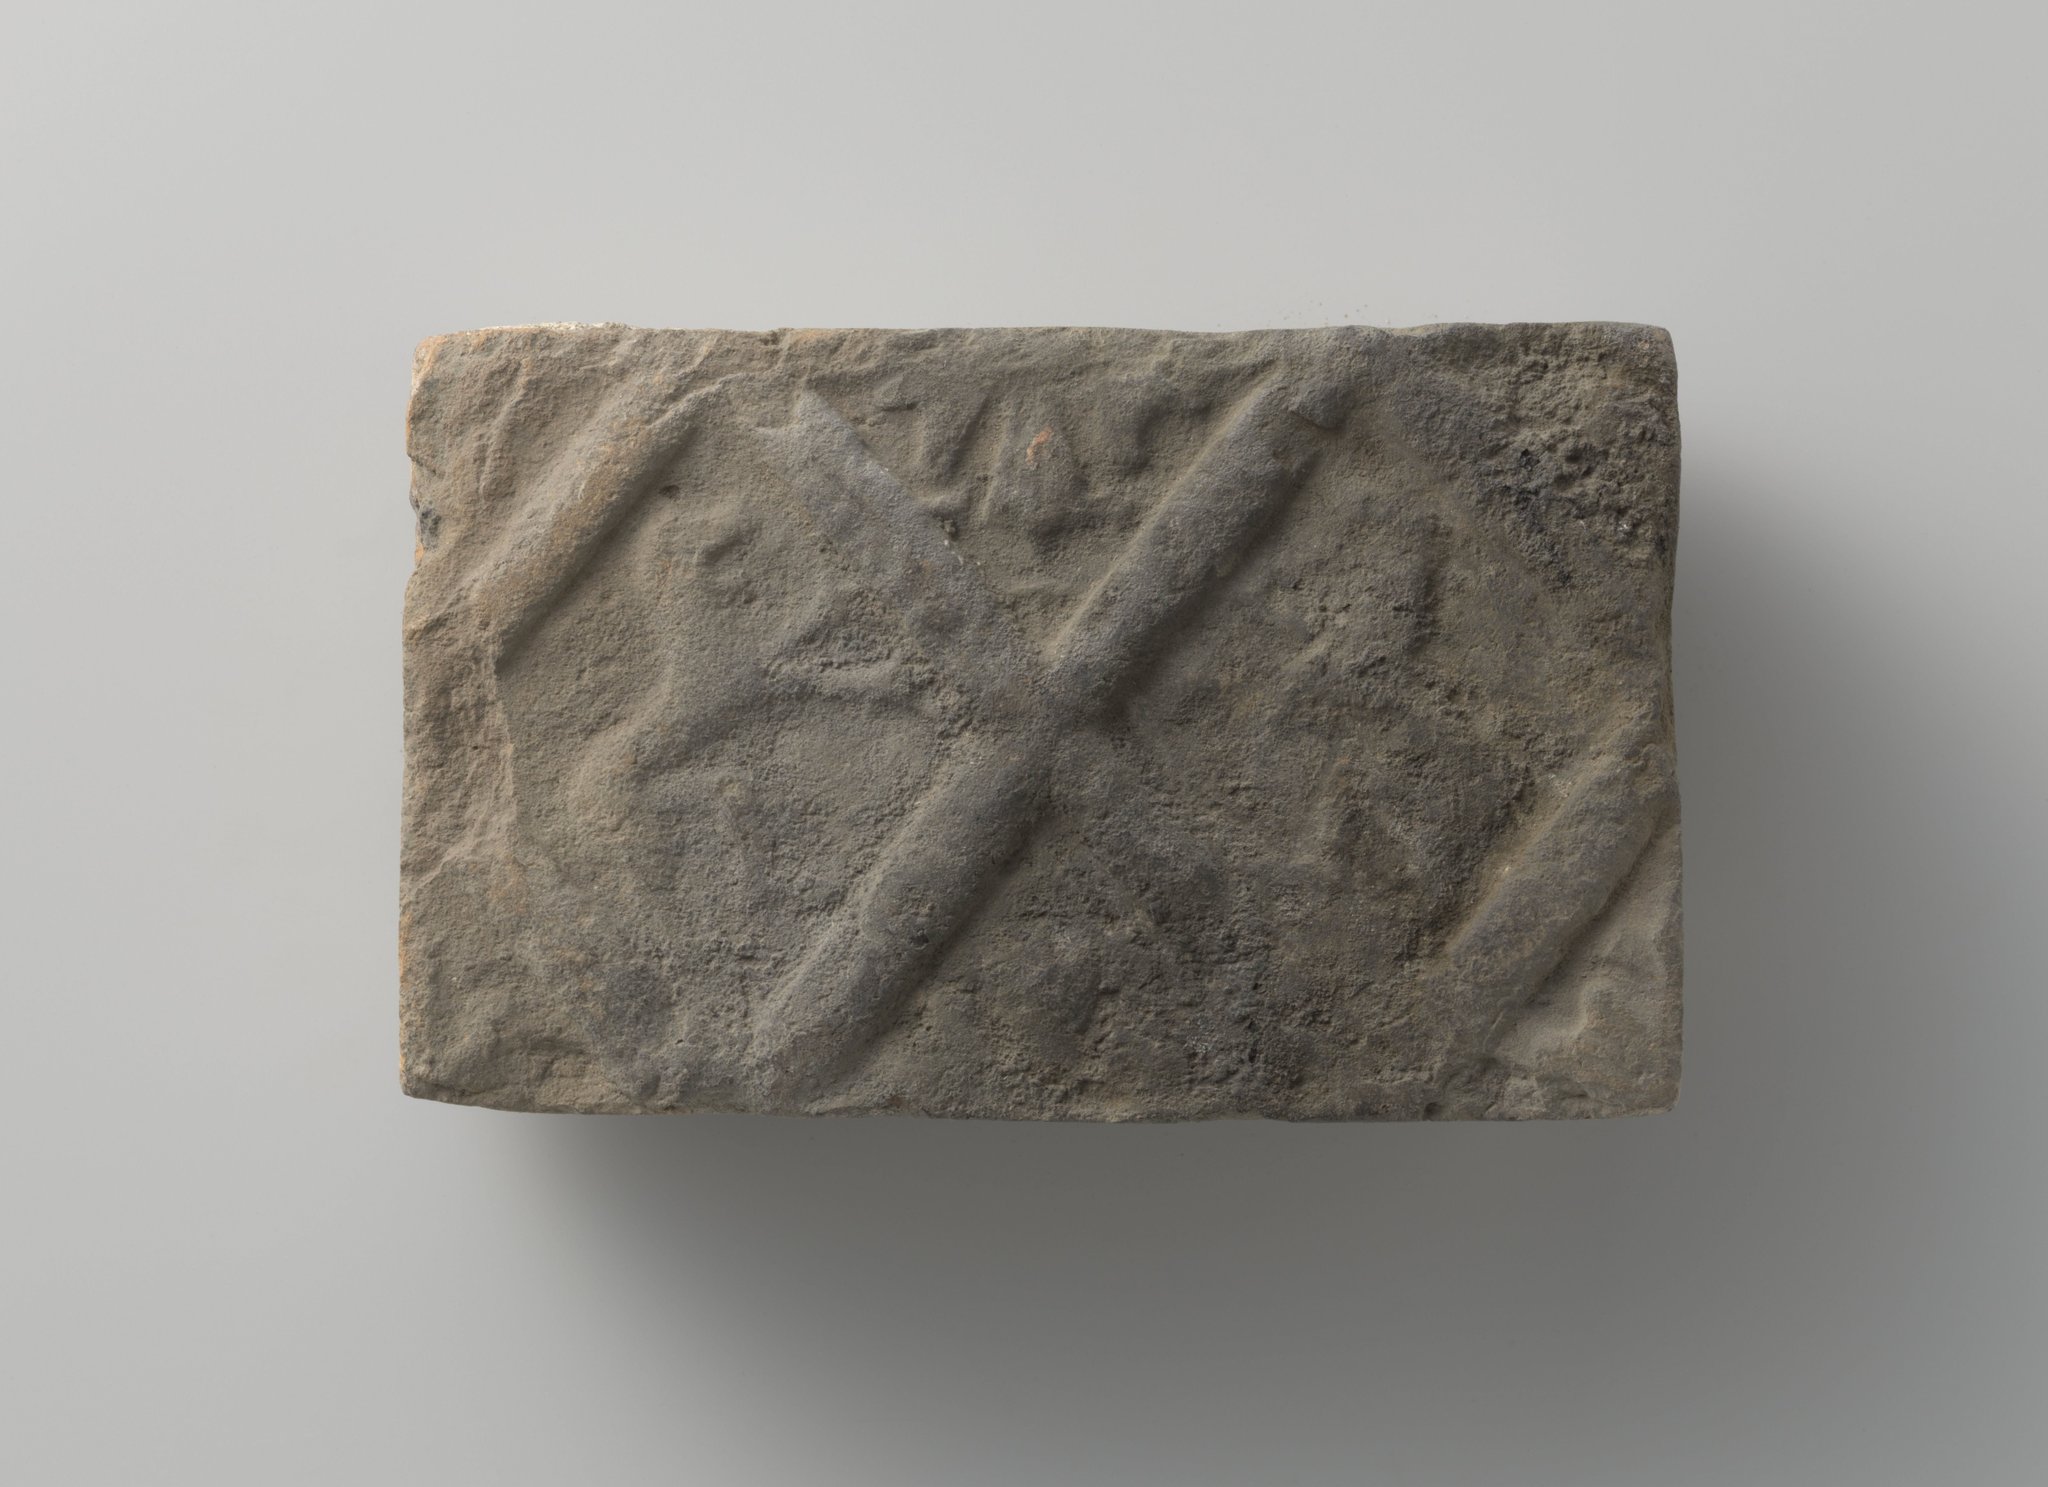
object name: hearthstone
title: Haardsteen met voorstelling van twee klimmende leeuwen, geplaatst in twee ruiten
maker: Anonymous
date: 1575-1625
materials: earthenware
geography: southern netherlands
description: Haardsteen met voorstelling van twee klimmende leeuwen, geplaatst in twee ruiten. De halve ruiten aan de boven- en onderkant zijn opgevuld met ruitvormige bloemen.